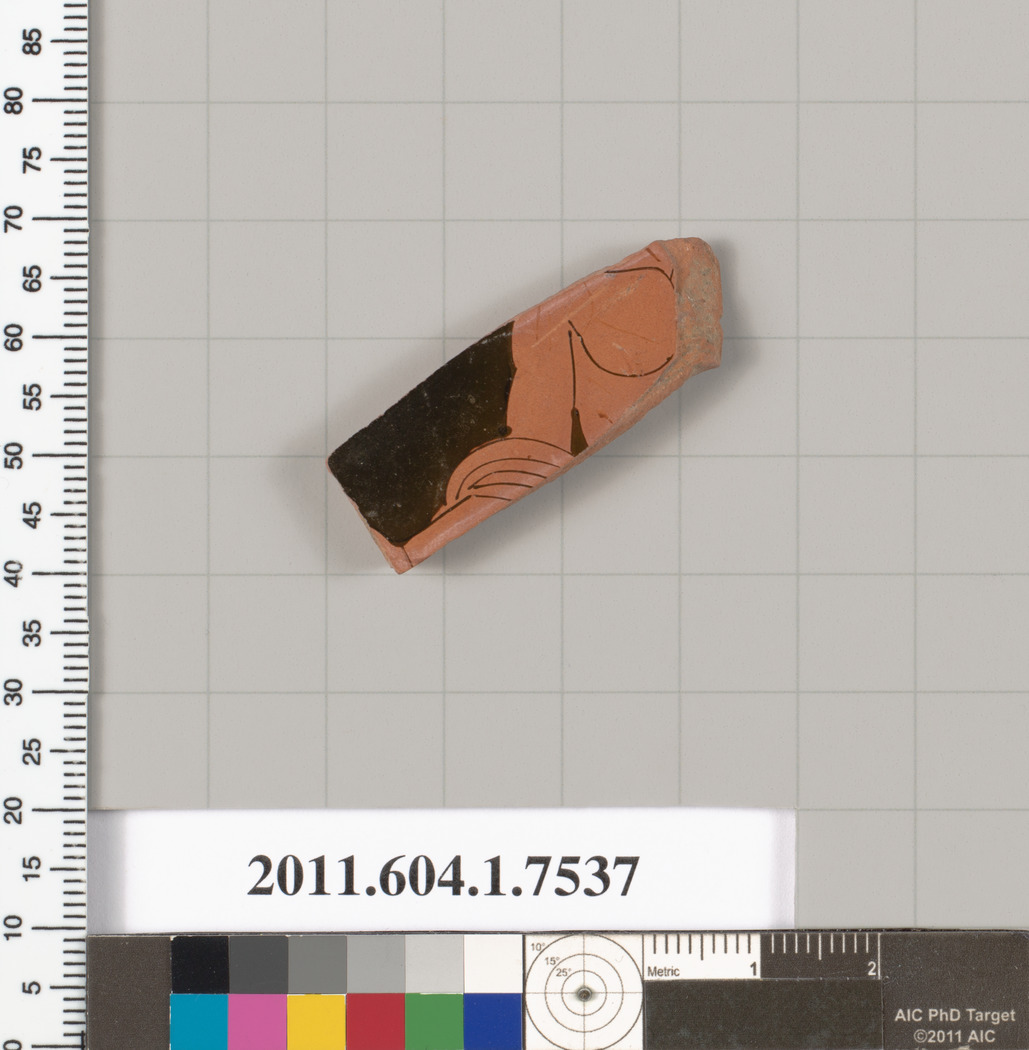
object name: kylix fragment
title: Terracotta fragment of a kylix (drinking cup)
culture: greek, attic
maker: euaion painter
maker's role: artist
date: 460-450 BCE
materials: terracotta